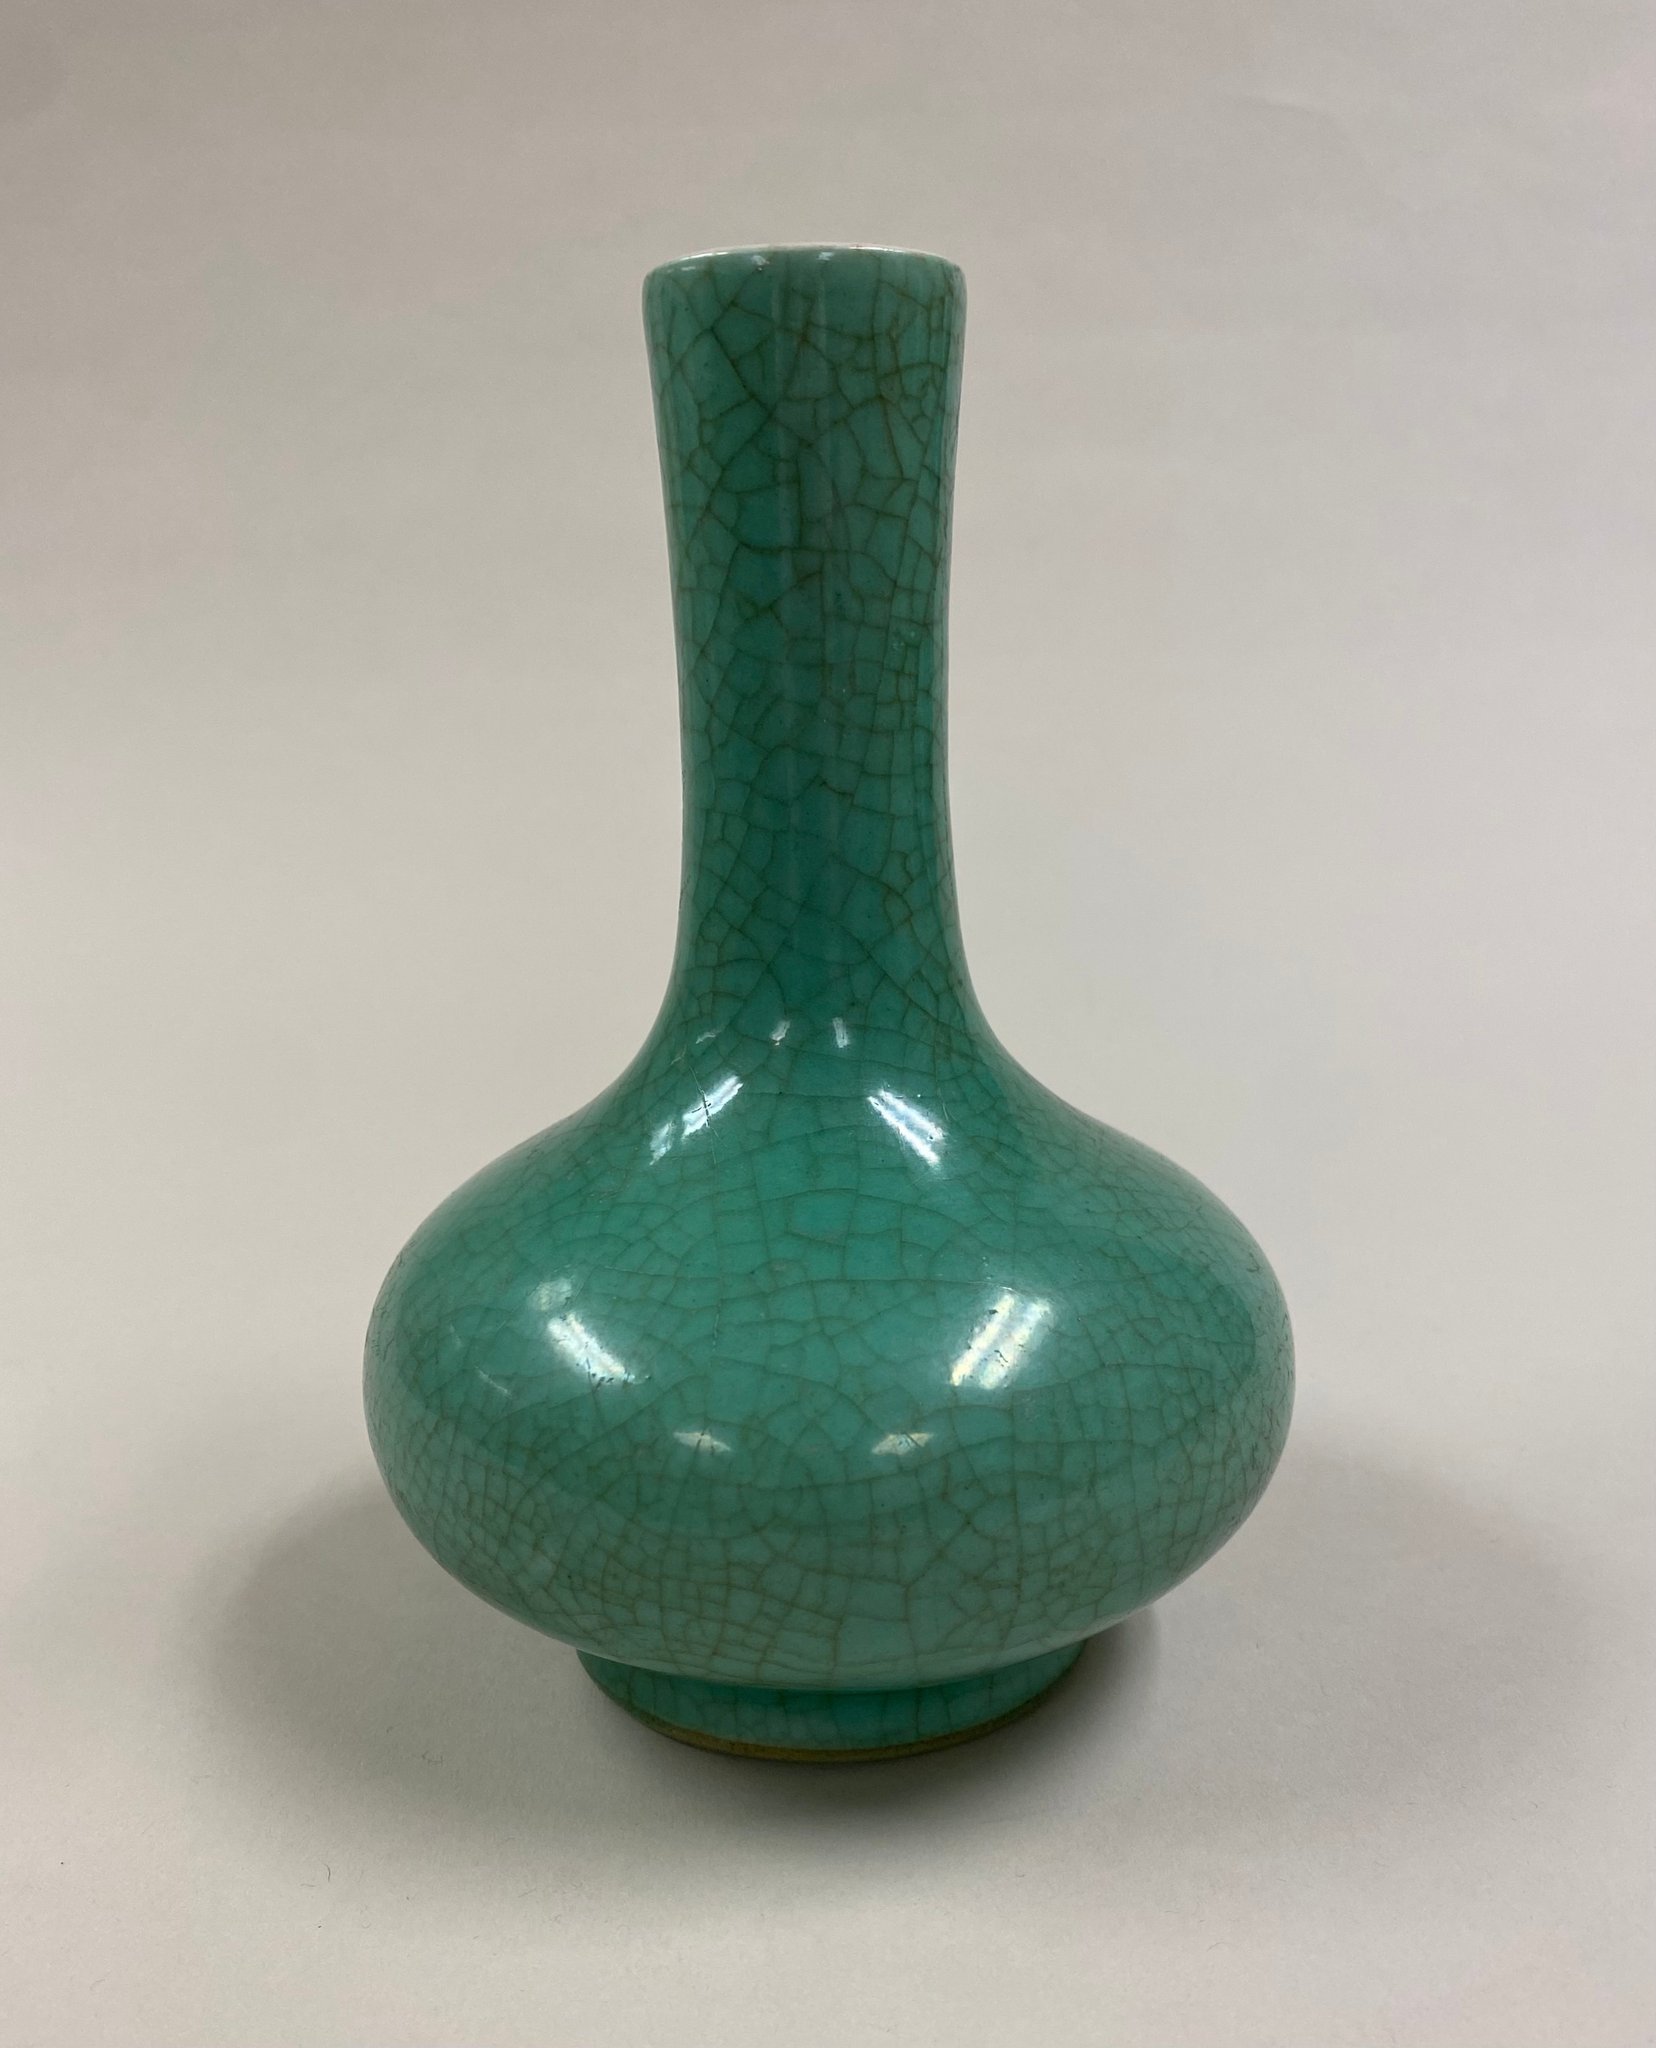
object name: vase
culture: chinese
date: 1667-1733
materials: glaze, porcelain